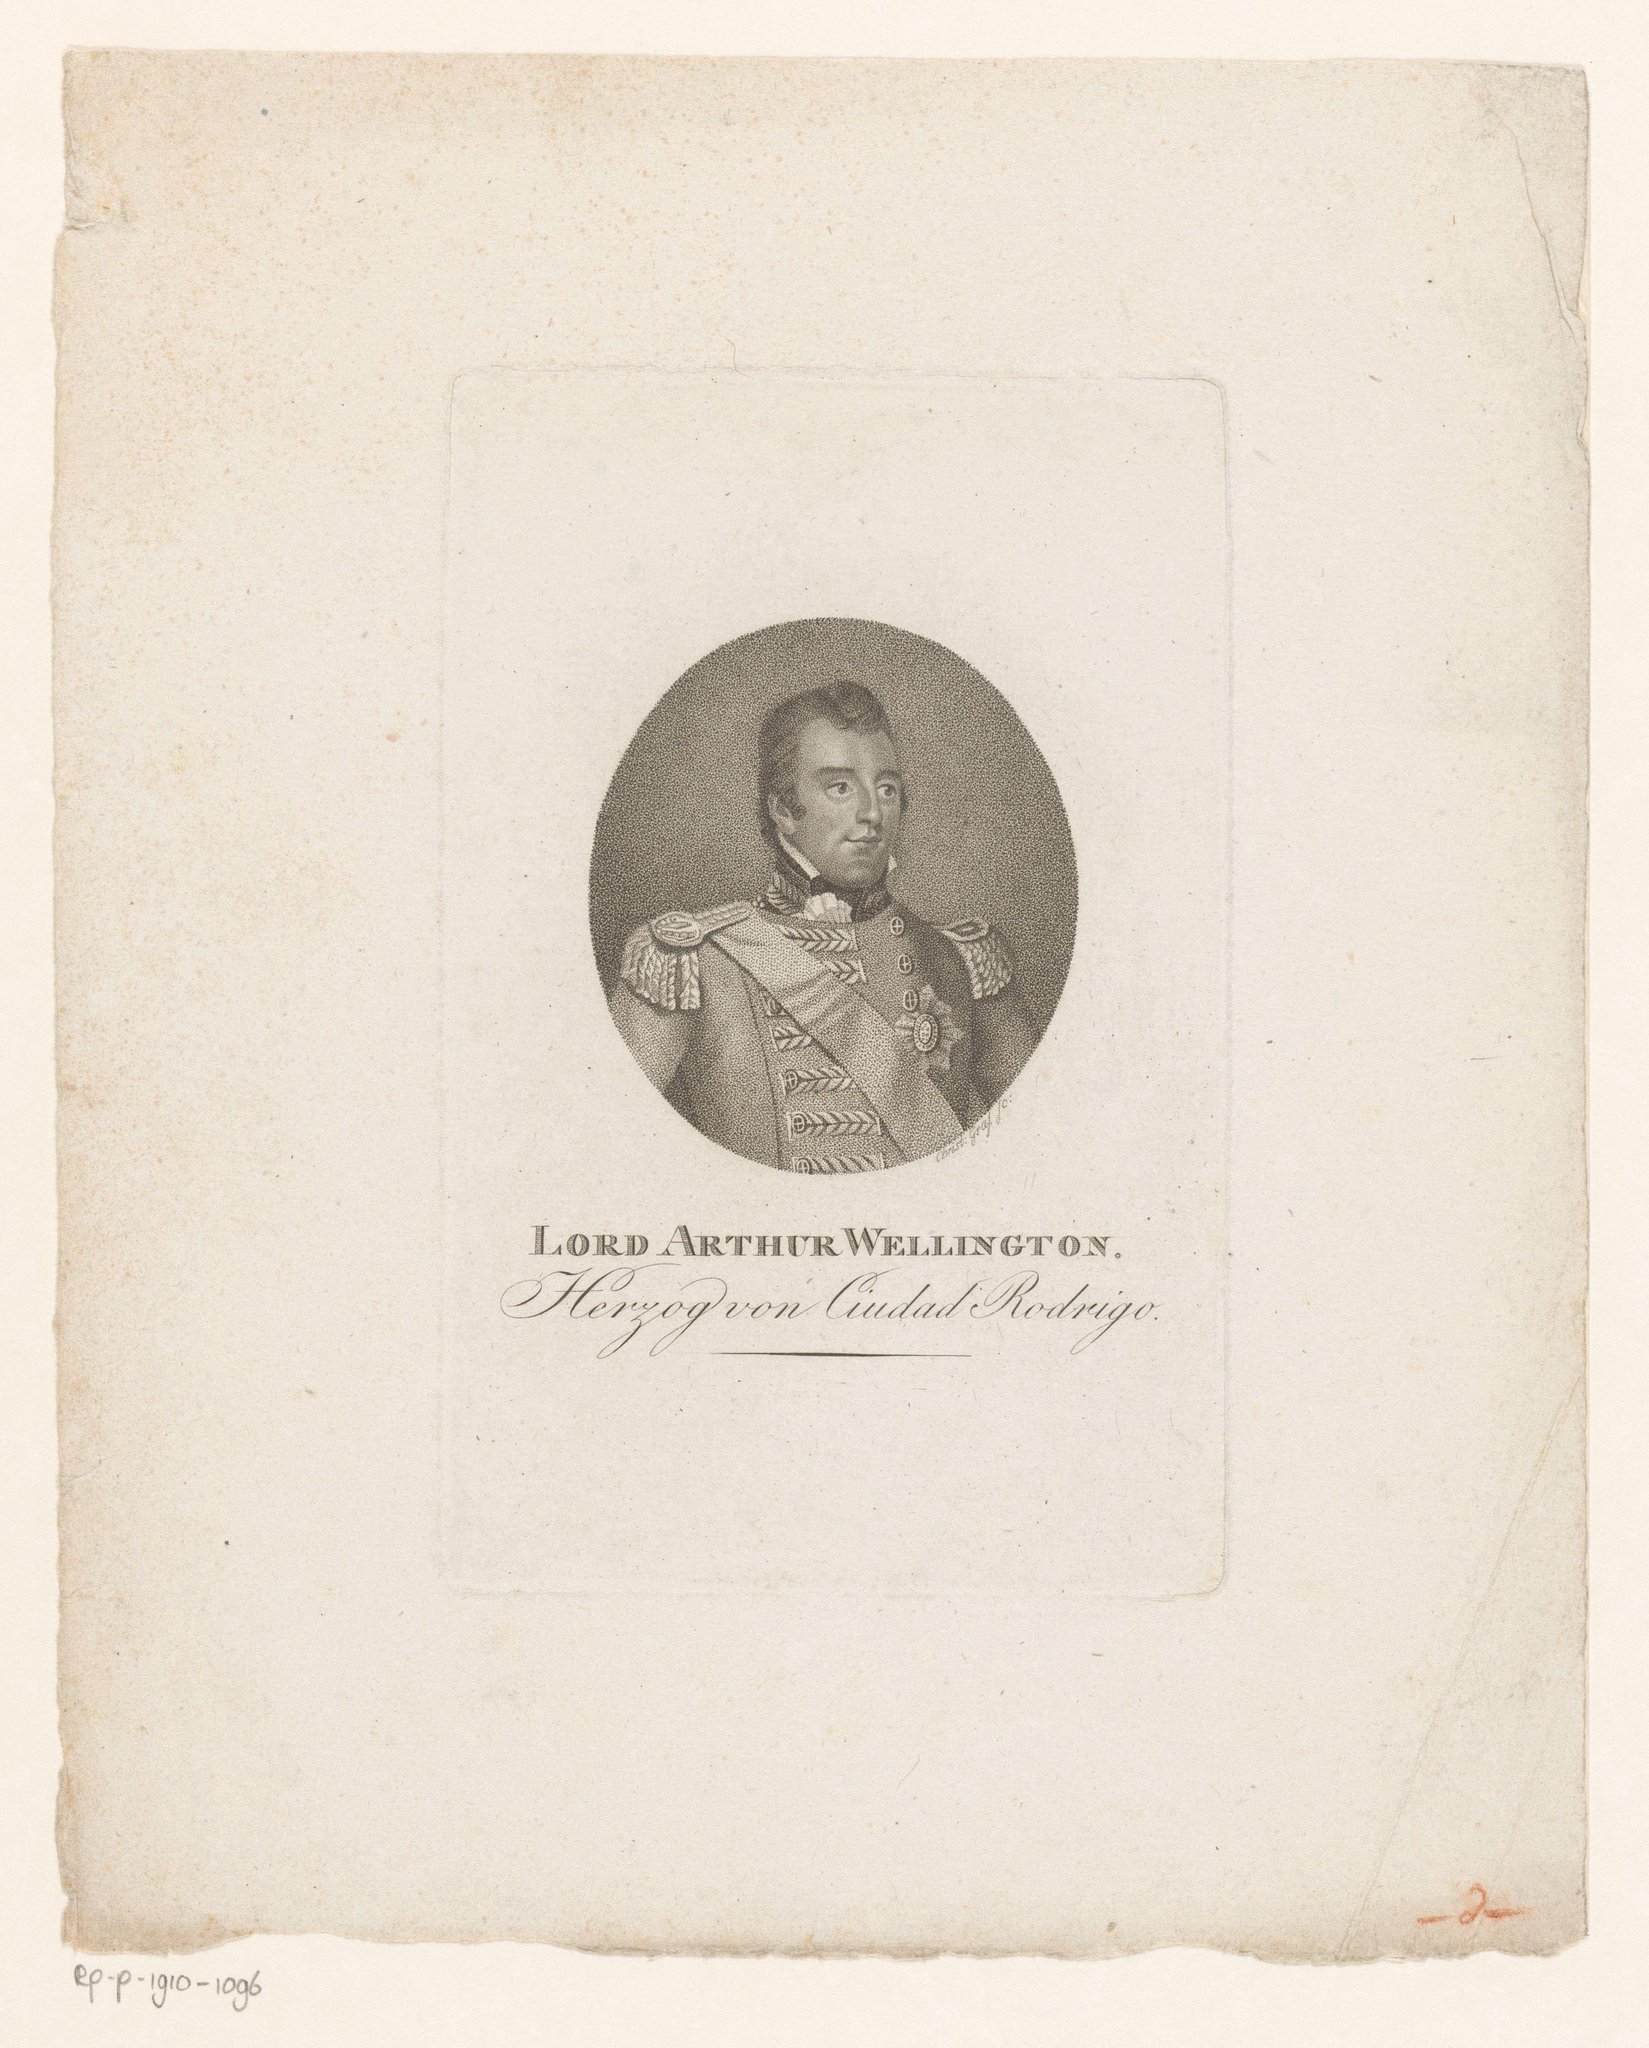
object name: print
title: Portret van Arthur Wellesley of Wellington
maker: christ. graf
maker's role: print maker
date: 1779-1852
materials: paper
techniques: stippling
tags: walmer castle, arthur wellesley of wellington, knighthood order, commander-in-chief, general, marshal, historical persons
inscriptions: collector's mark: Lugt 2228